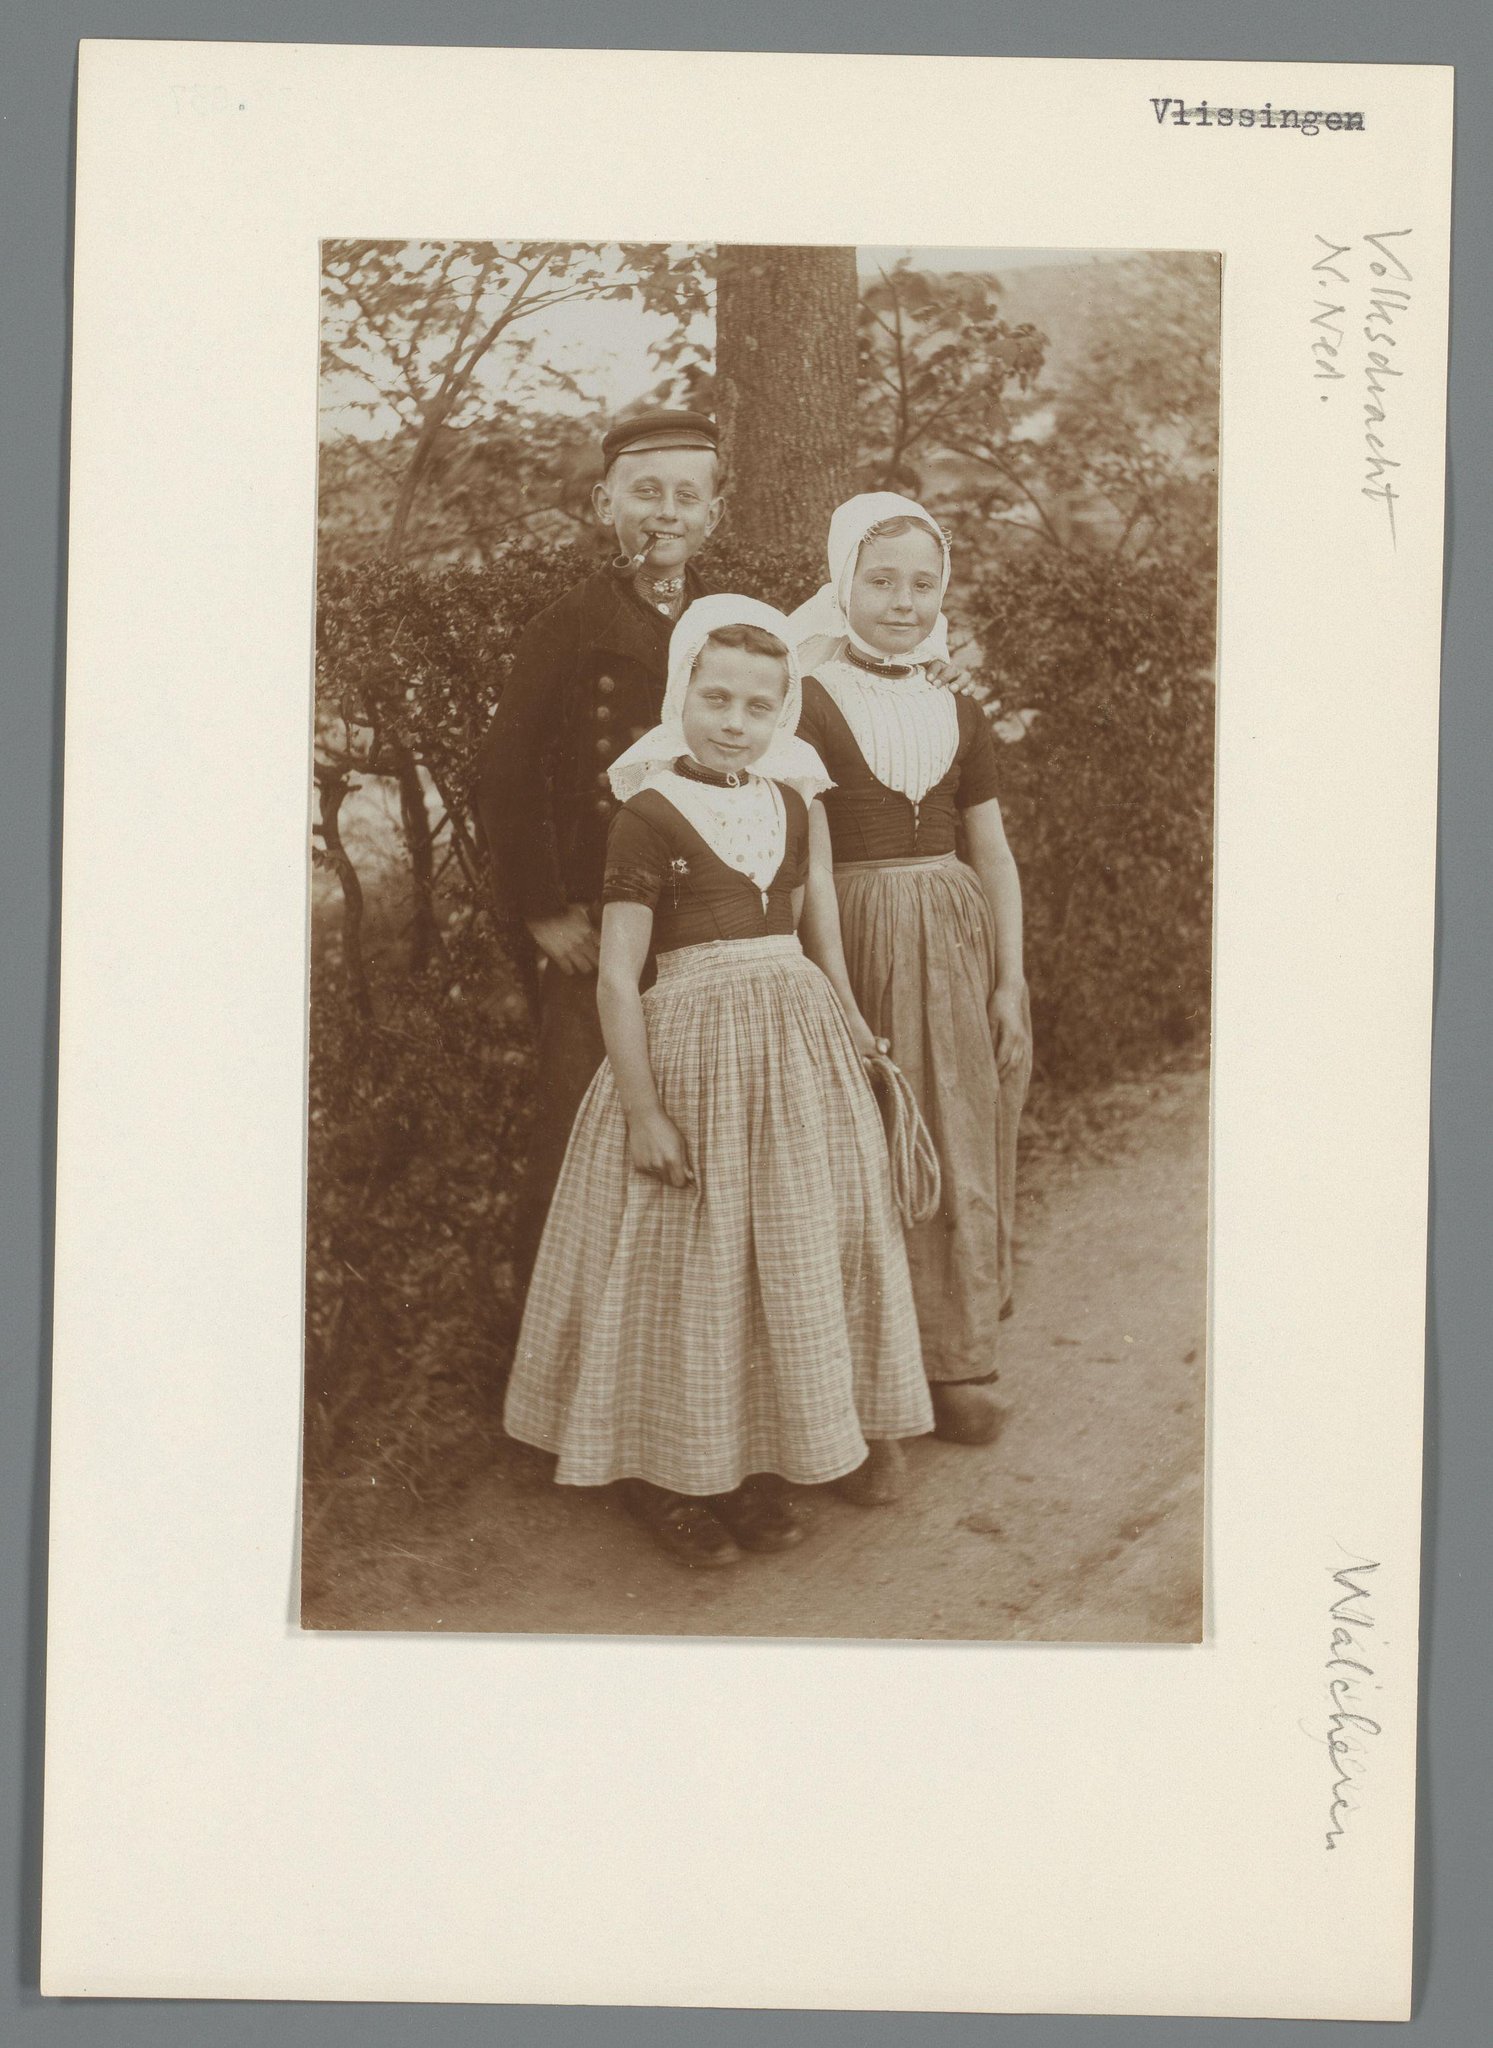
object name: photograph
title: Drie kinderen in Walcherse kinderdracht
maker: Anonymous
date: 1880-1920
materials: paper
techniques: collodion silver print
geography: walcheren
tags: historical persons, folk costume, regional costume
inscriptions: inscription: ‘Volksdracht/ N.Ned./ Walcheren’, number: ‘32.837’, number: ‘- 527078’